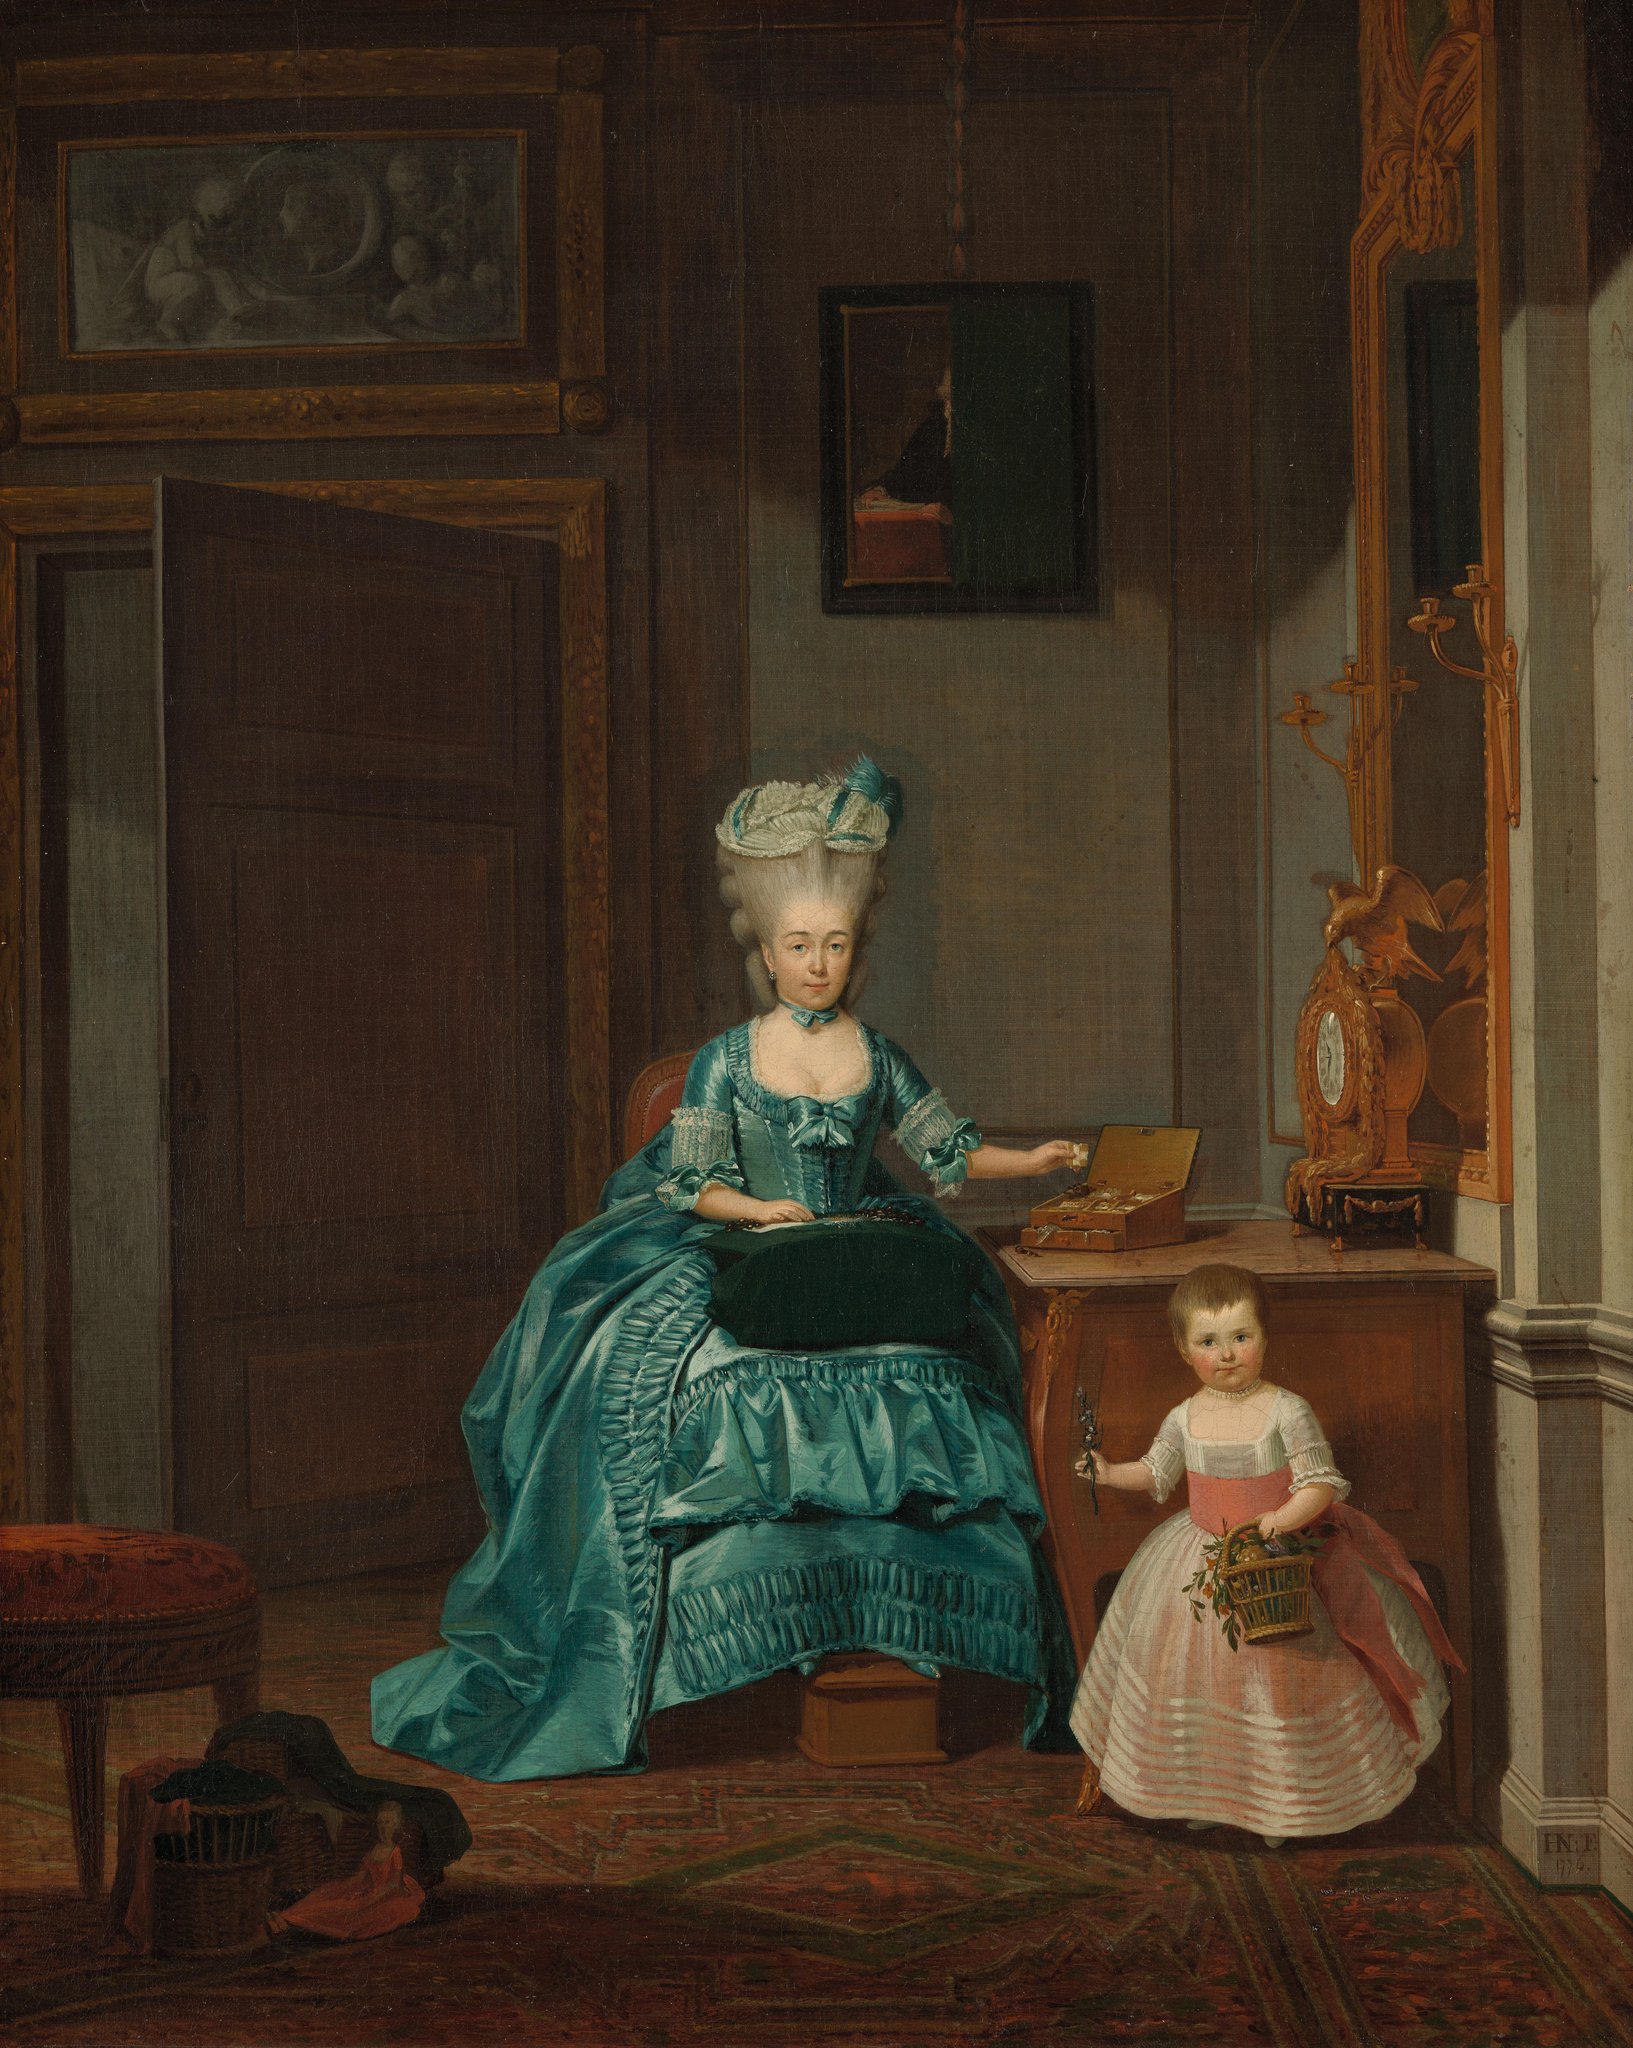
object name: painting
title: Portrait of Suzanna Cornelia Mogge and her Daughter Johanna Ferdinanda van Collen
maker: hermanus numan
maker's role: draughtsman, painter, print maker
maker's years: 1744-1820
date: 1776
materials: canvas, oil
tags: historical persons - bb - woman, lace-making, interior of the house, mother and daughter(s) (family group)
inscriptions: signature and date: ‘HN: F: 1776’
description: This portrait captures the 23-year-old Susanna Mogge on the occasion of her marriage to the banker Hendrik Muilman. Behind her hangs the portrait of her first, deceased husband, the little girl’s father. Upon marrying Muilman, Mogge brought with her Haamstede Castle near Zierikzee and the Zeeland seigneuries of Koudekerke and Welland. Her blue gown and high-coiffed hairstyle allude to the festivities surrounding this wedding.